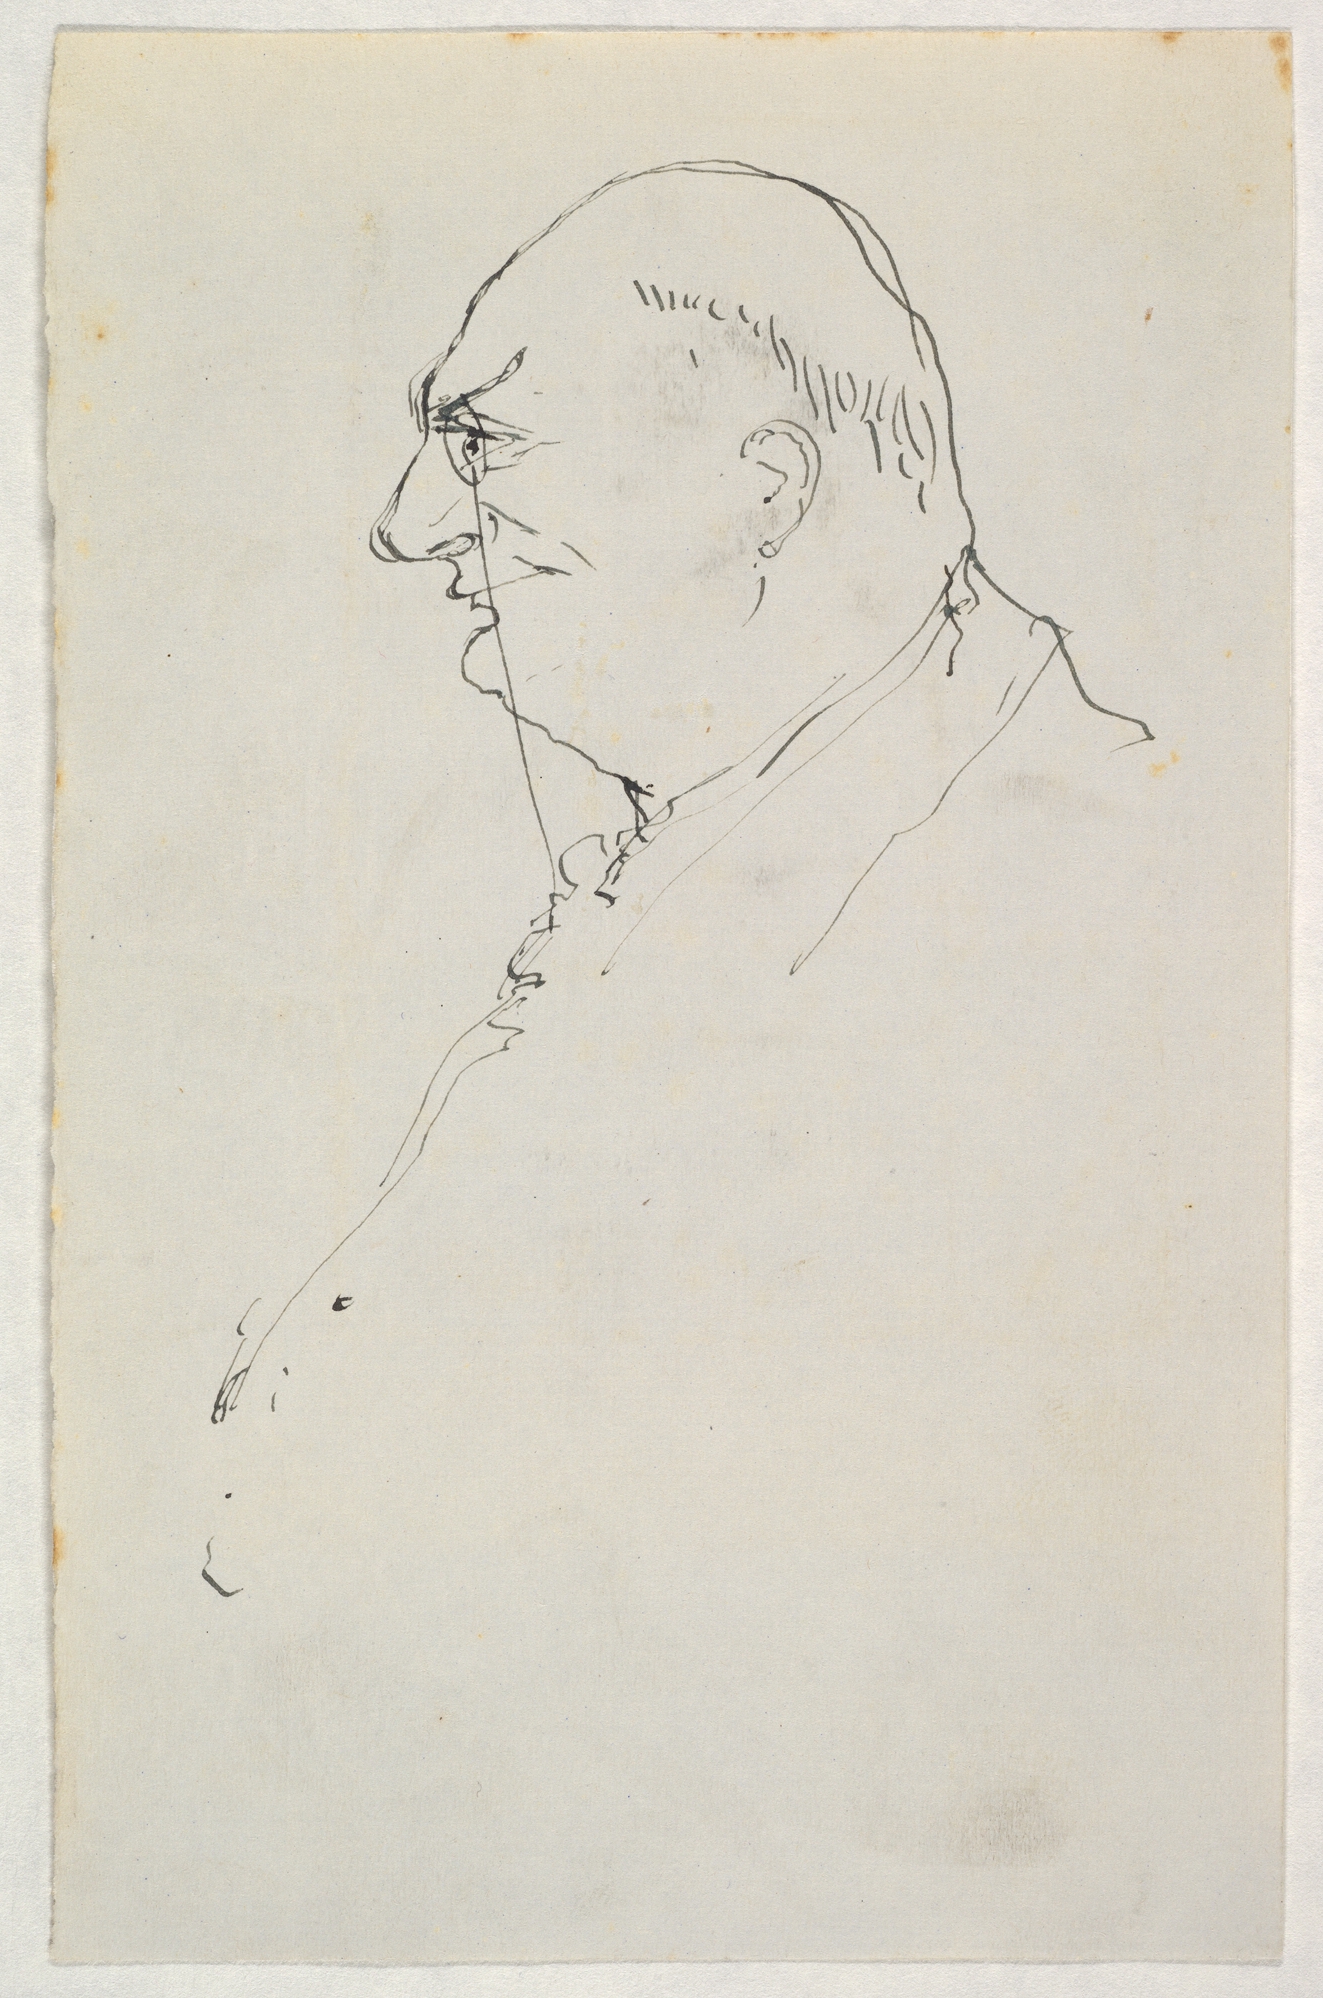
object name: drawing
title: Caricature of a man in profile wearing a monocle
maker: anonymous, british, 19th century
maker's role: artist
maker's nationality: british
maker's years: 1800-1900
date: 1880-1900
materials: ink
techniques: pen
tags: men,caricature